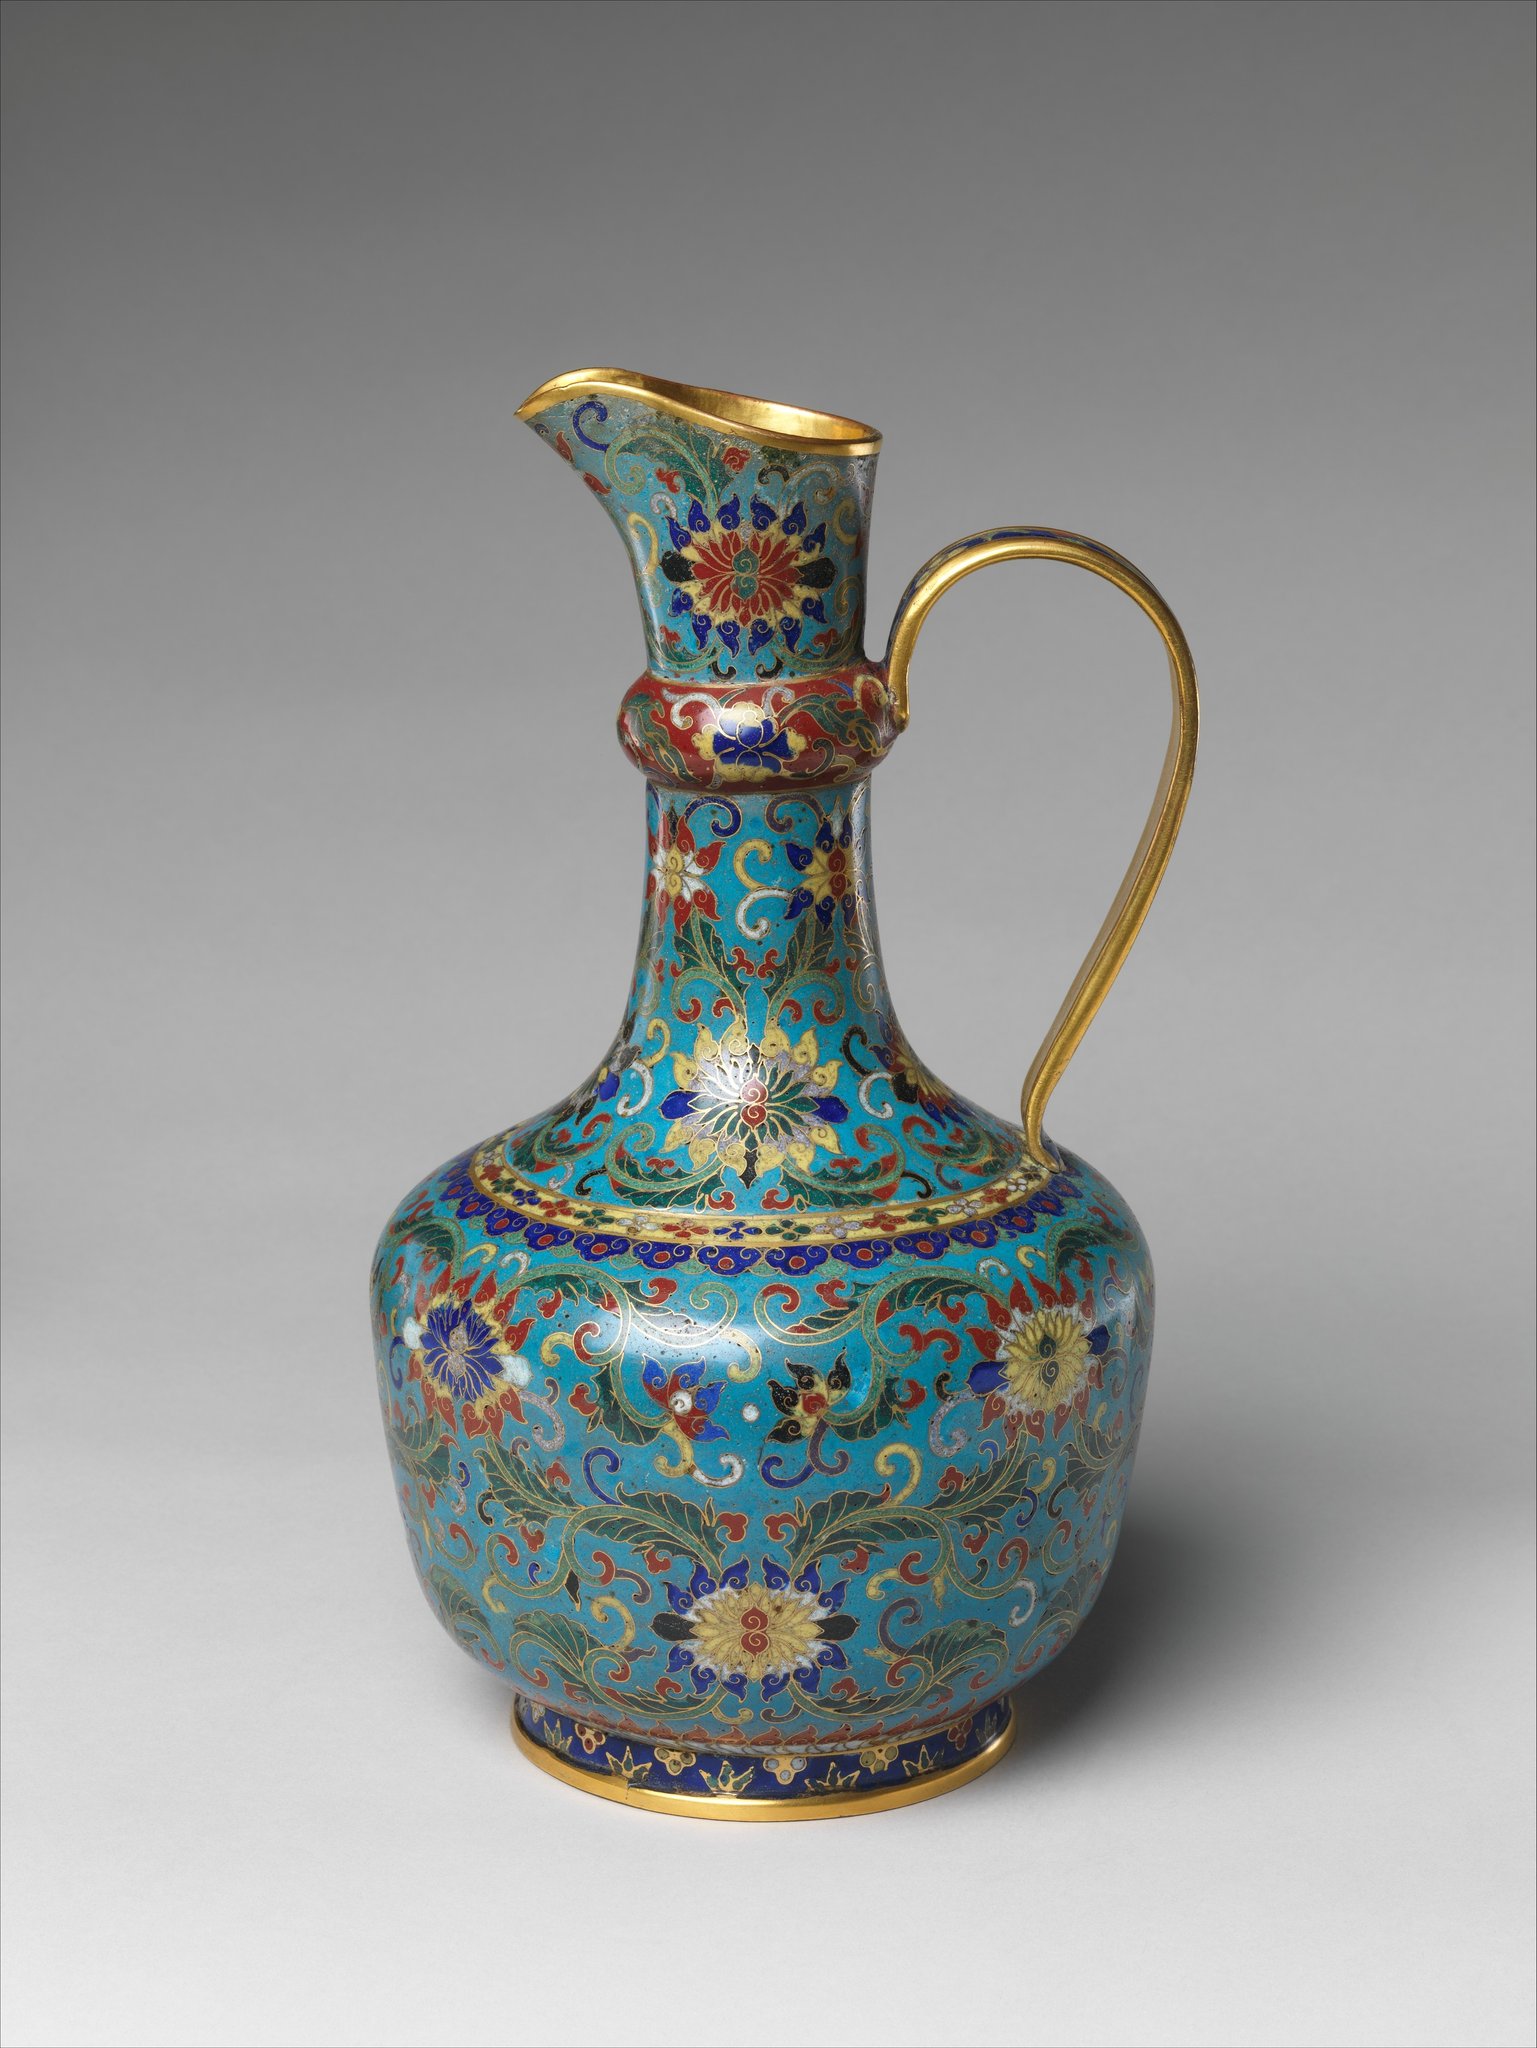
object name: ewer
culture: chinese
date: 1701-1800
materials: enamel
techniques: enamel